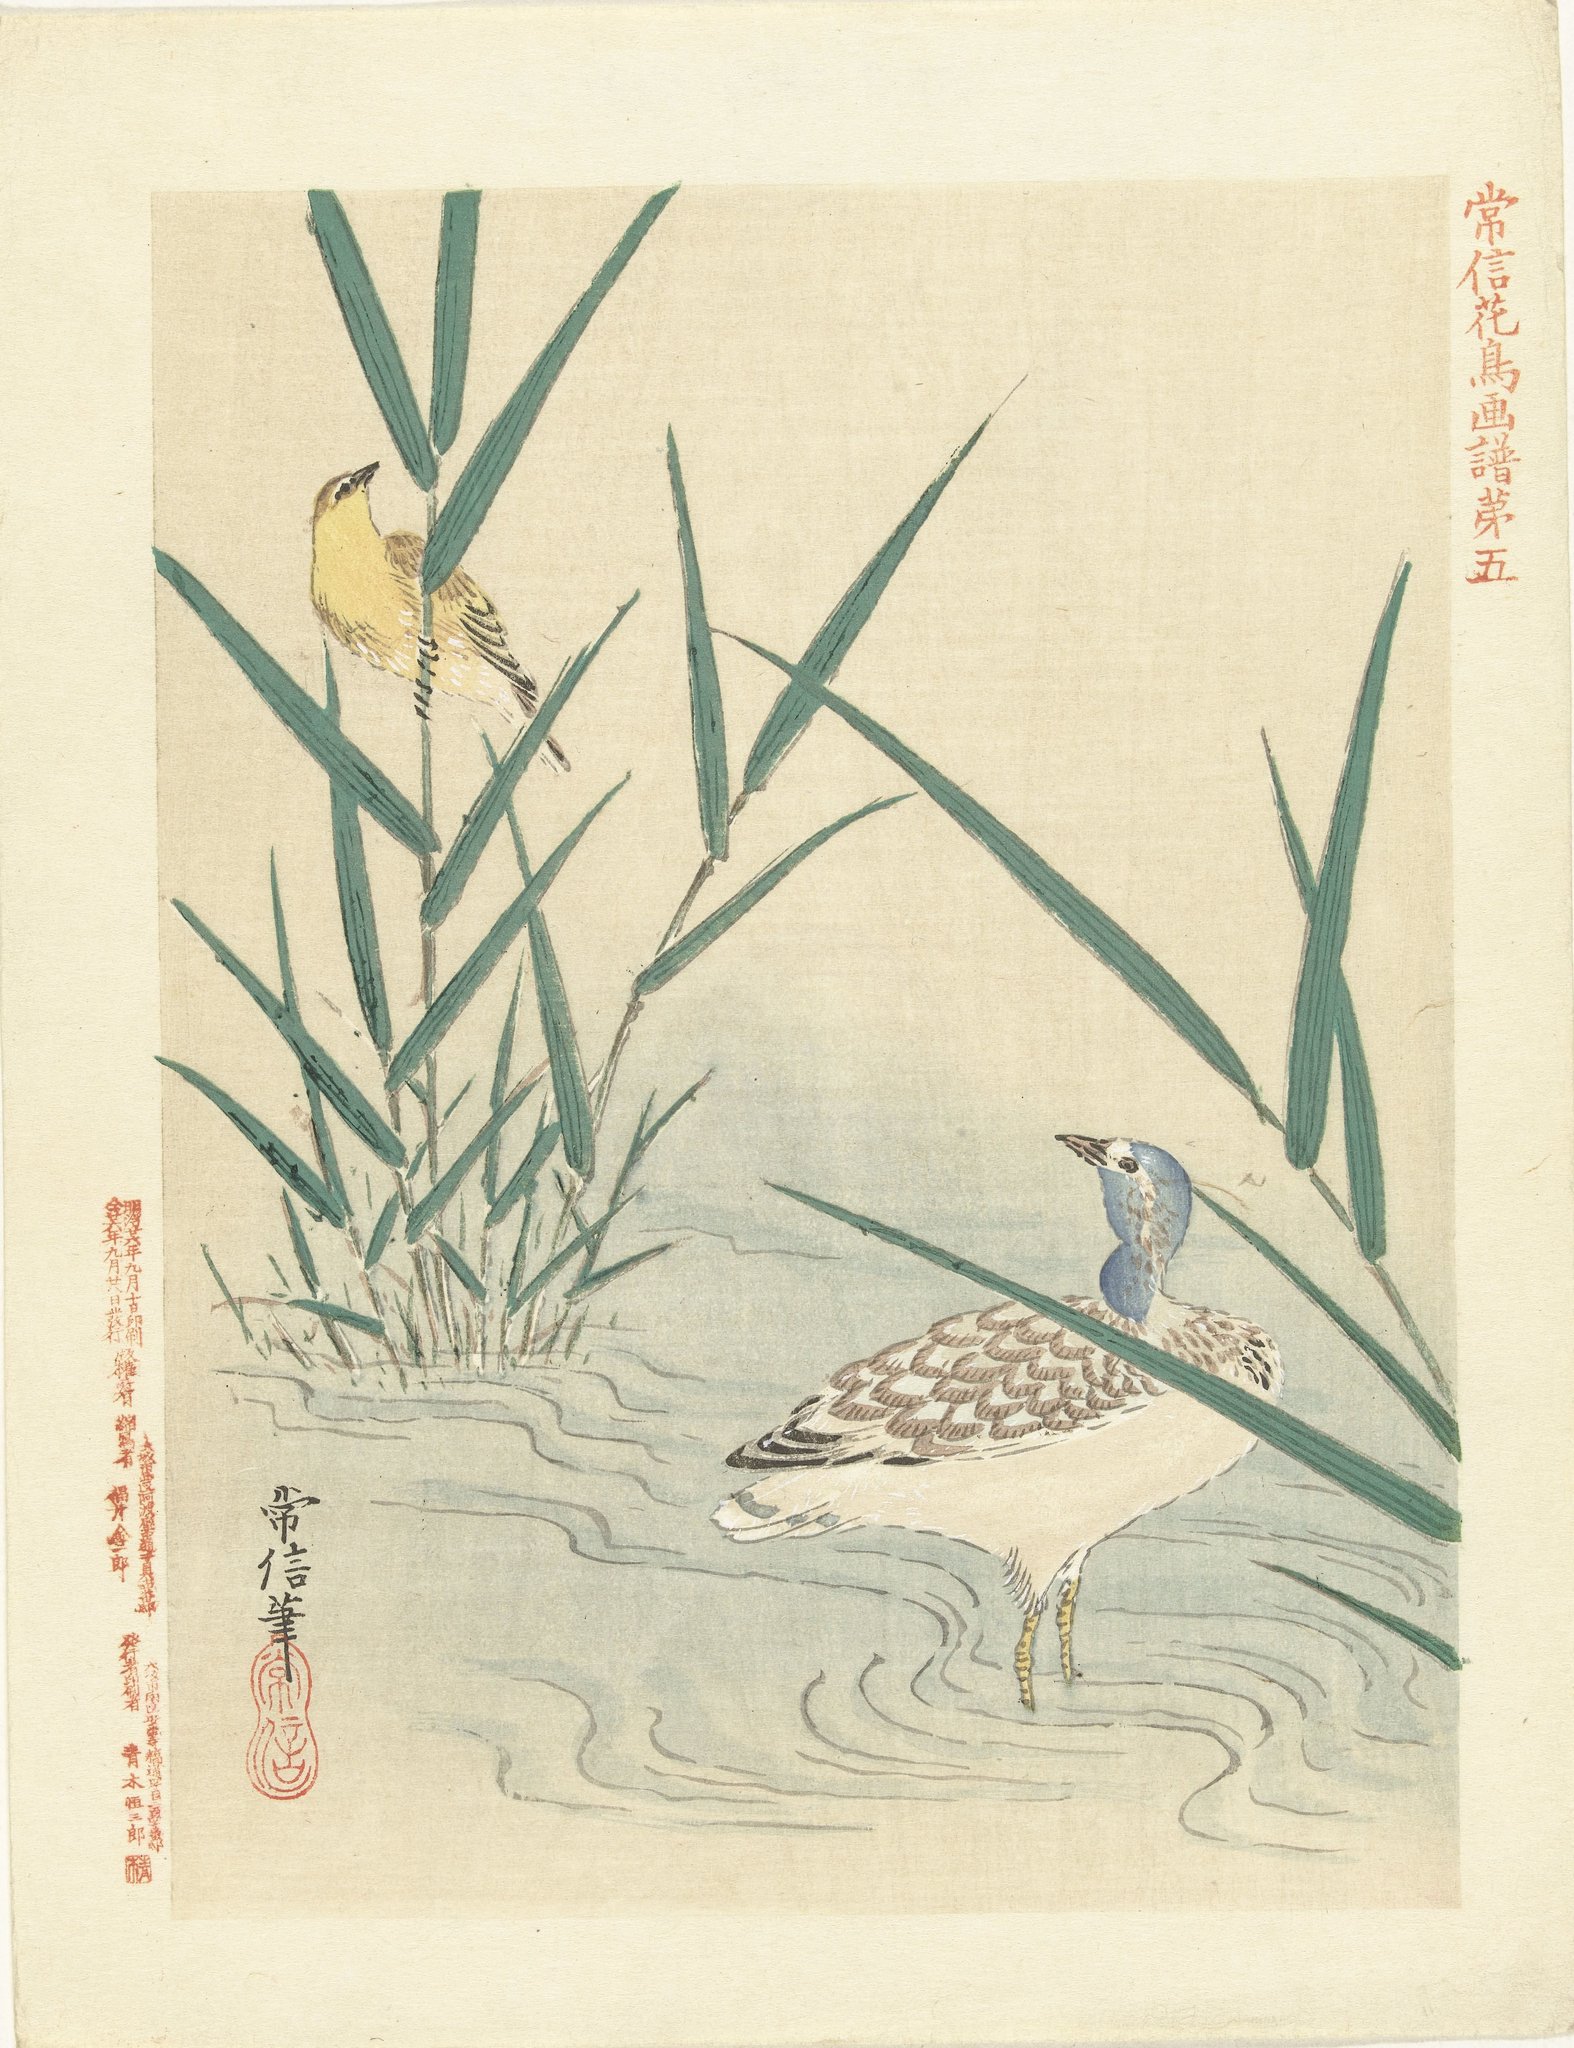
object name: print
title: Watervogel kijkend naar gele zangvogel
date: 1809-1893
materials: paper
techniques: woodcut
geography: osaka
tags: water course, water-birds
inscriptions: collector's mark: Lugt 2228, collector's mark: ‘Rijksschool voor kunstnijverheid’ Lugt 3937